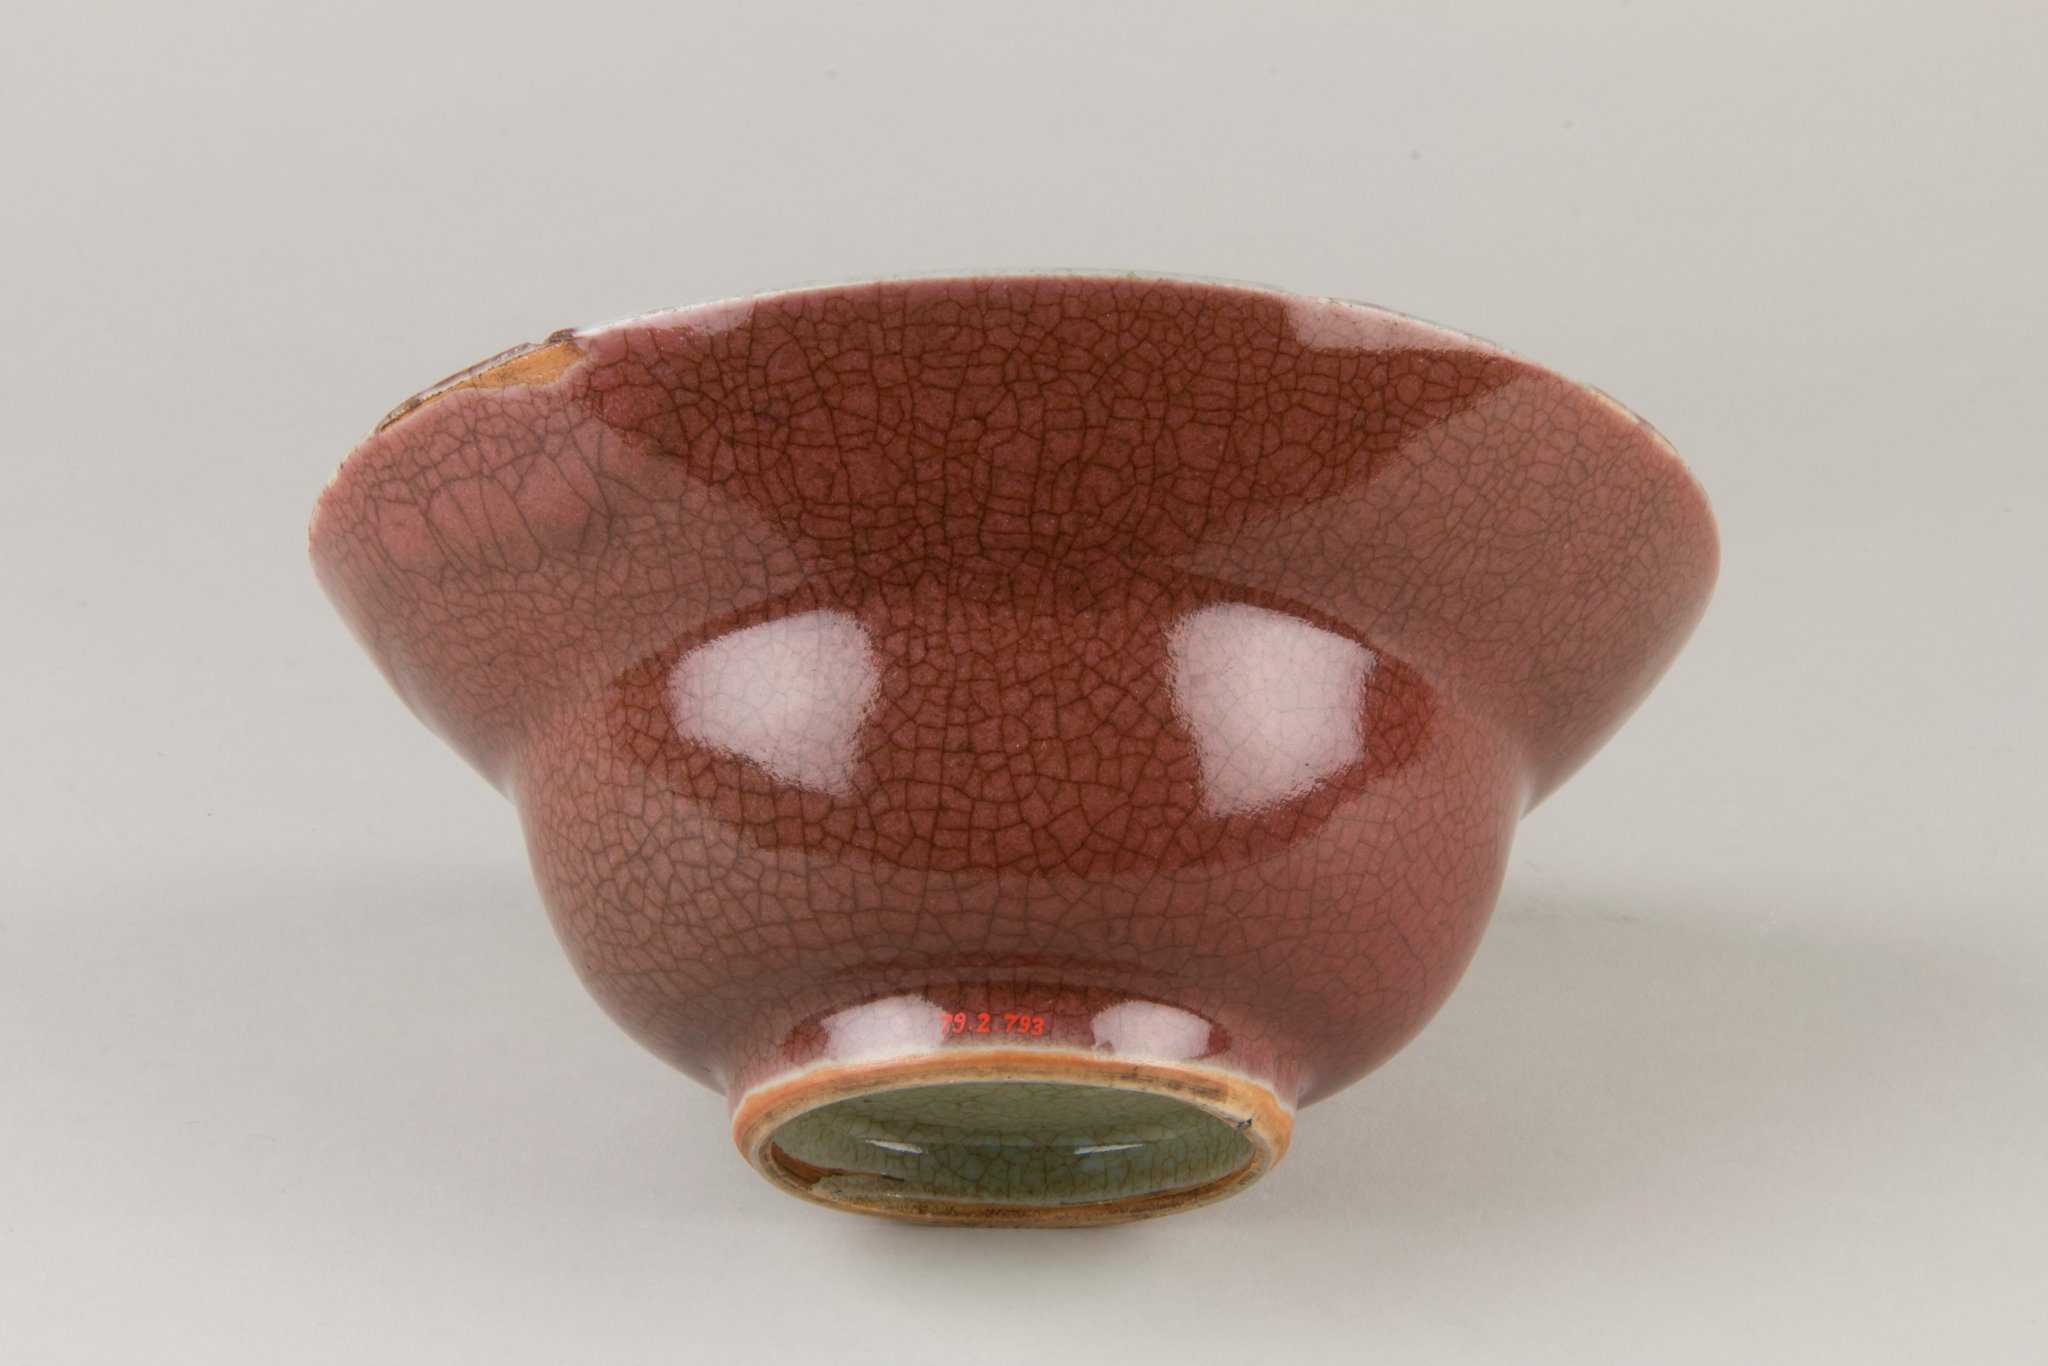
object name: bowl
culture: chinese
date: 1667-1733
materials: glaze, porcelain